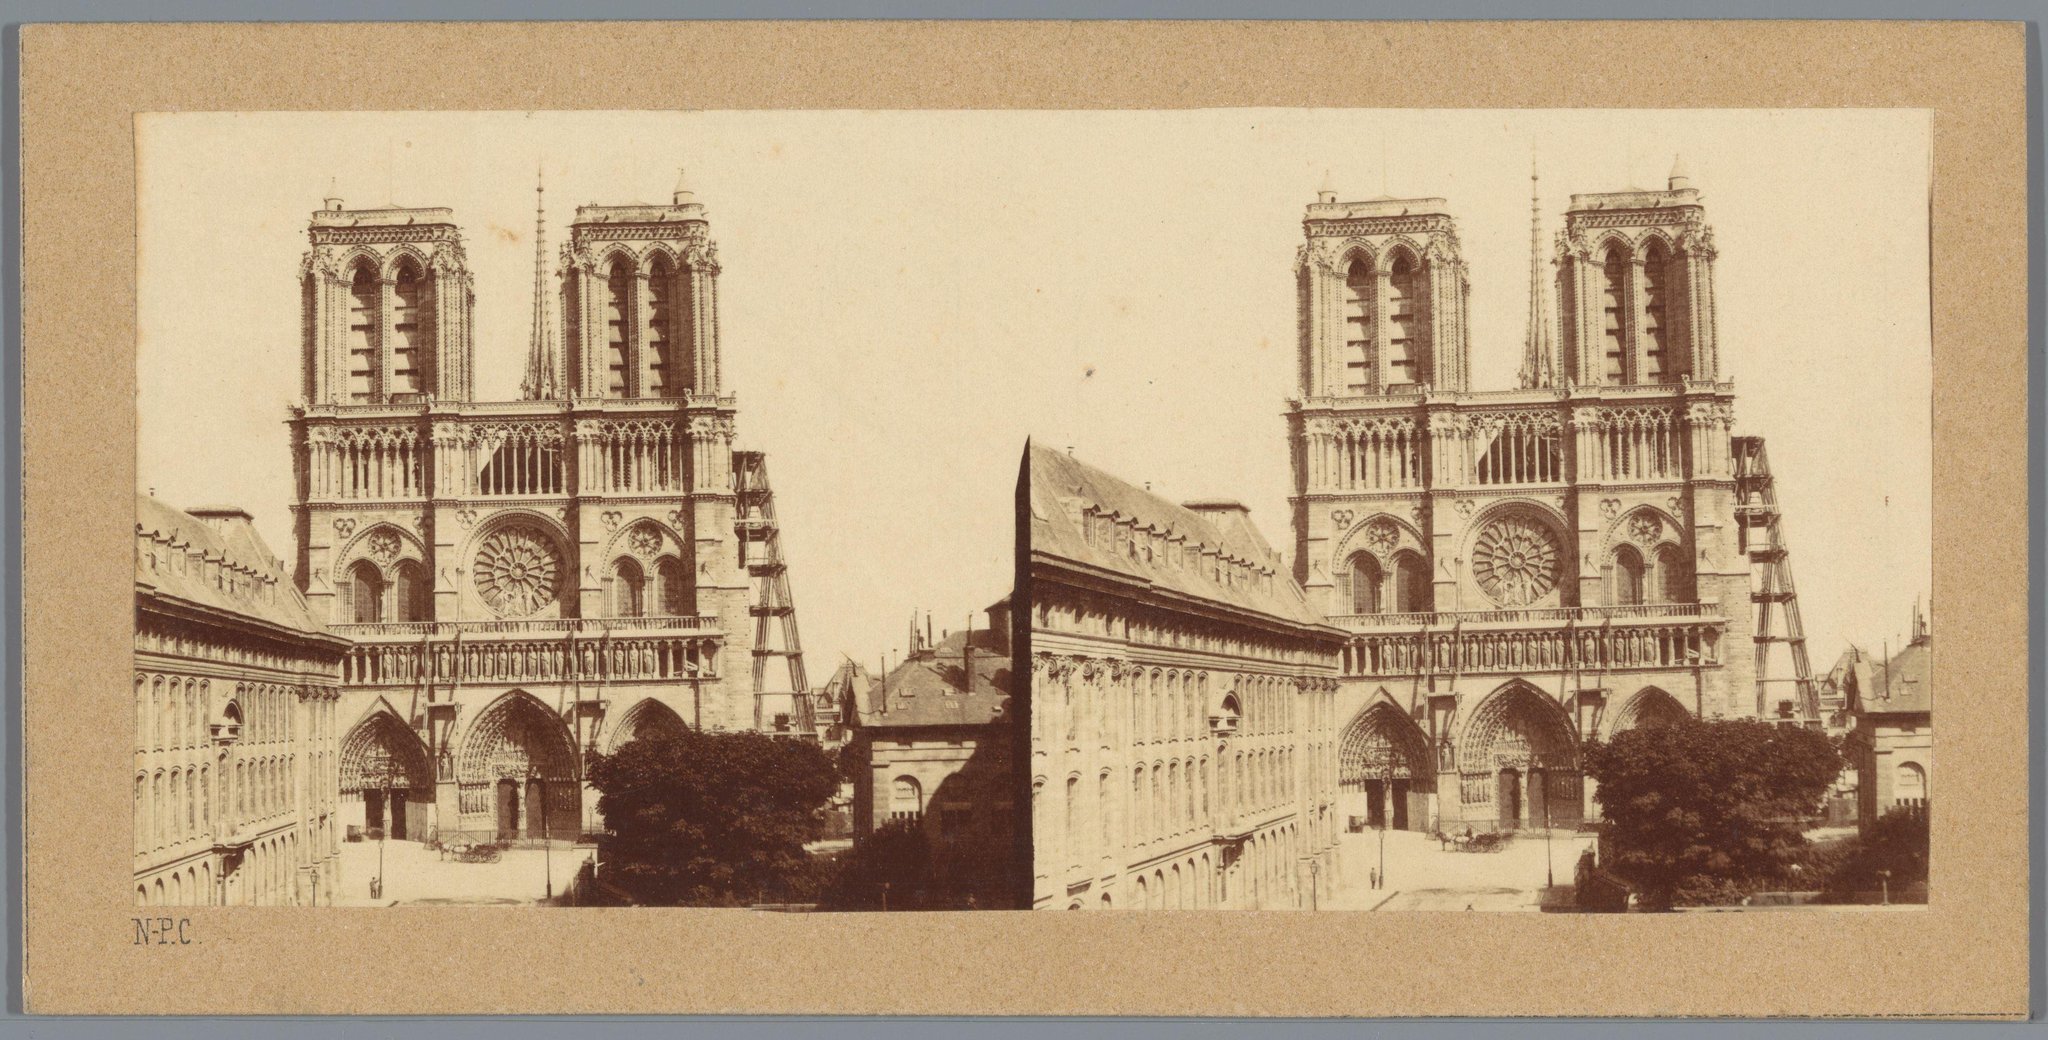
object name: stereograph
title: Gezicht op de façade van de Notre-Dame in Parijs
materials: cardboard, photographic support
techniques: albumen print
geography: paris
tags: parts of church exterior and annexes: façade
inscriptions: number: ‘14.’, monogram: ‘N.P.C.’, inscription: ‘facade Notre Dame de Paris’